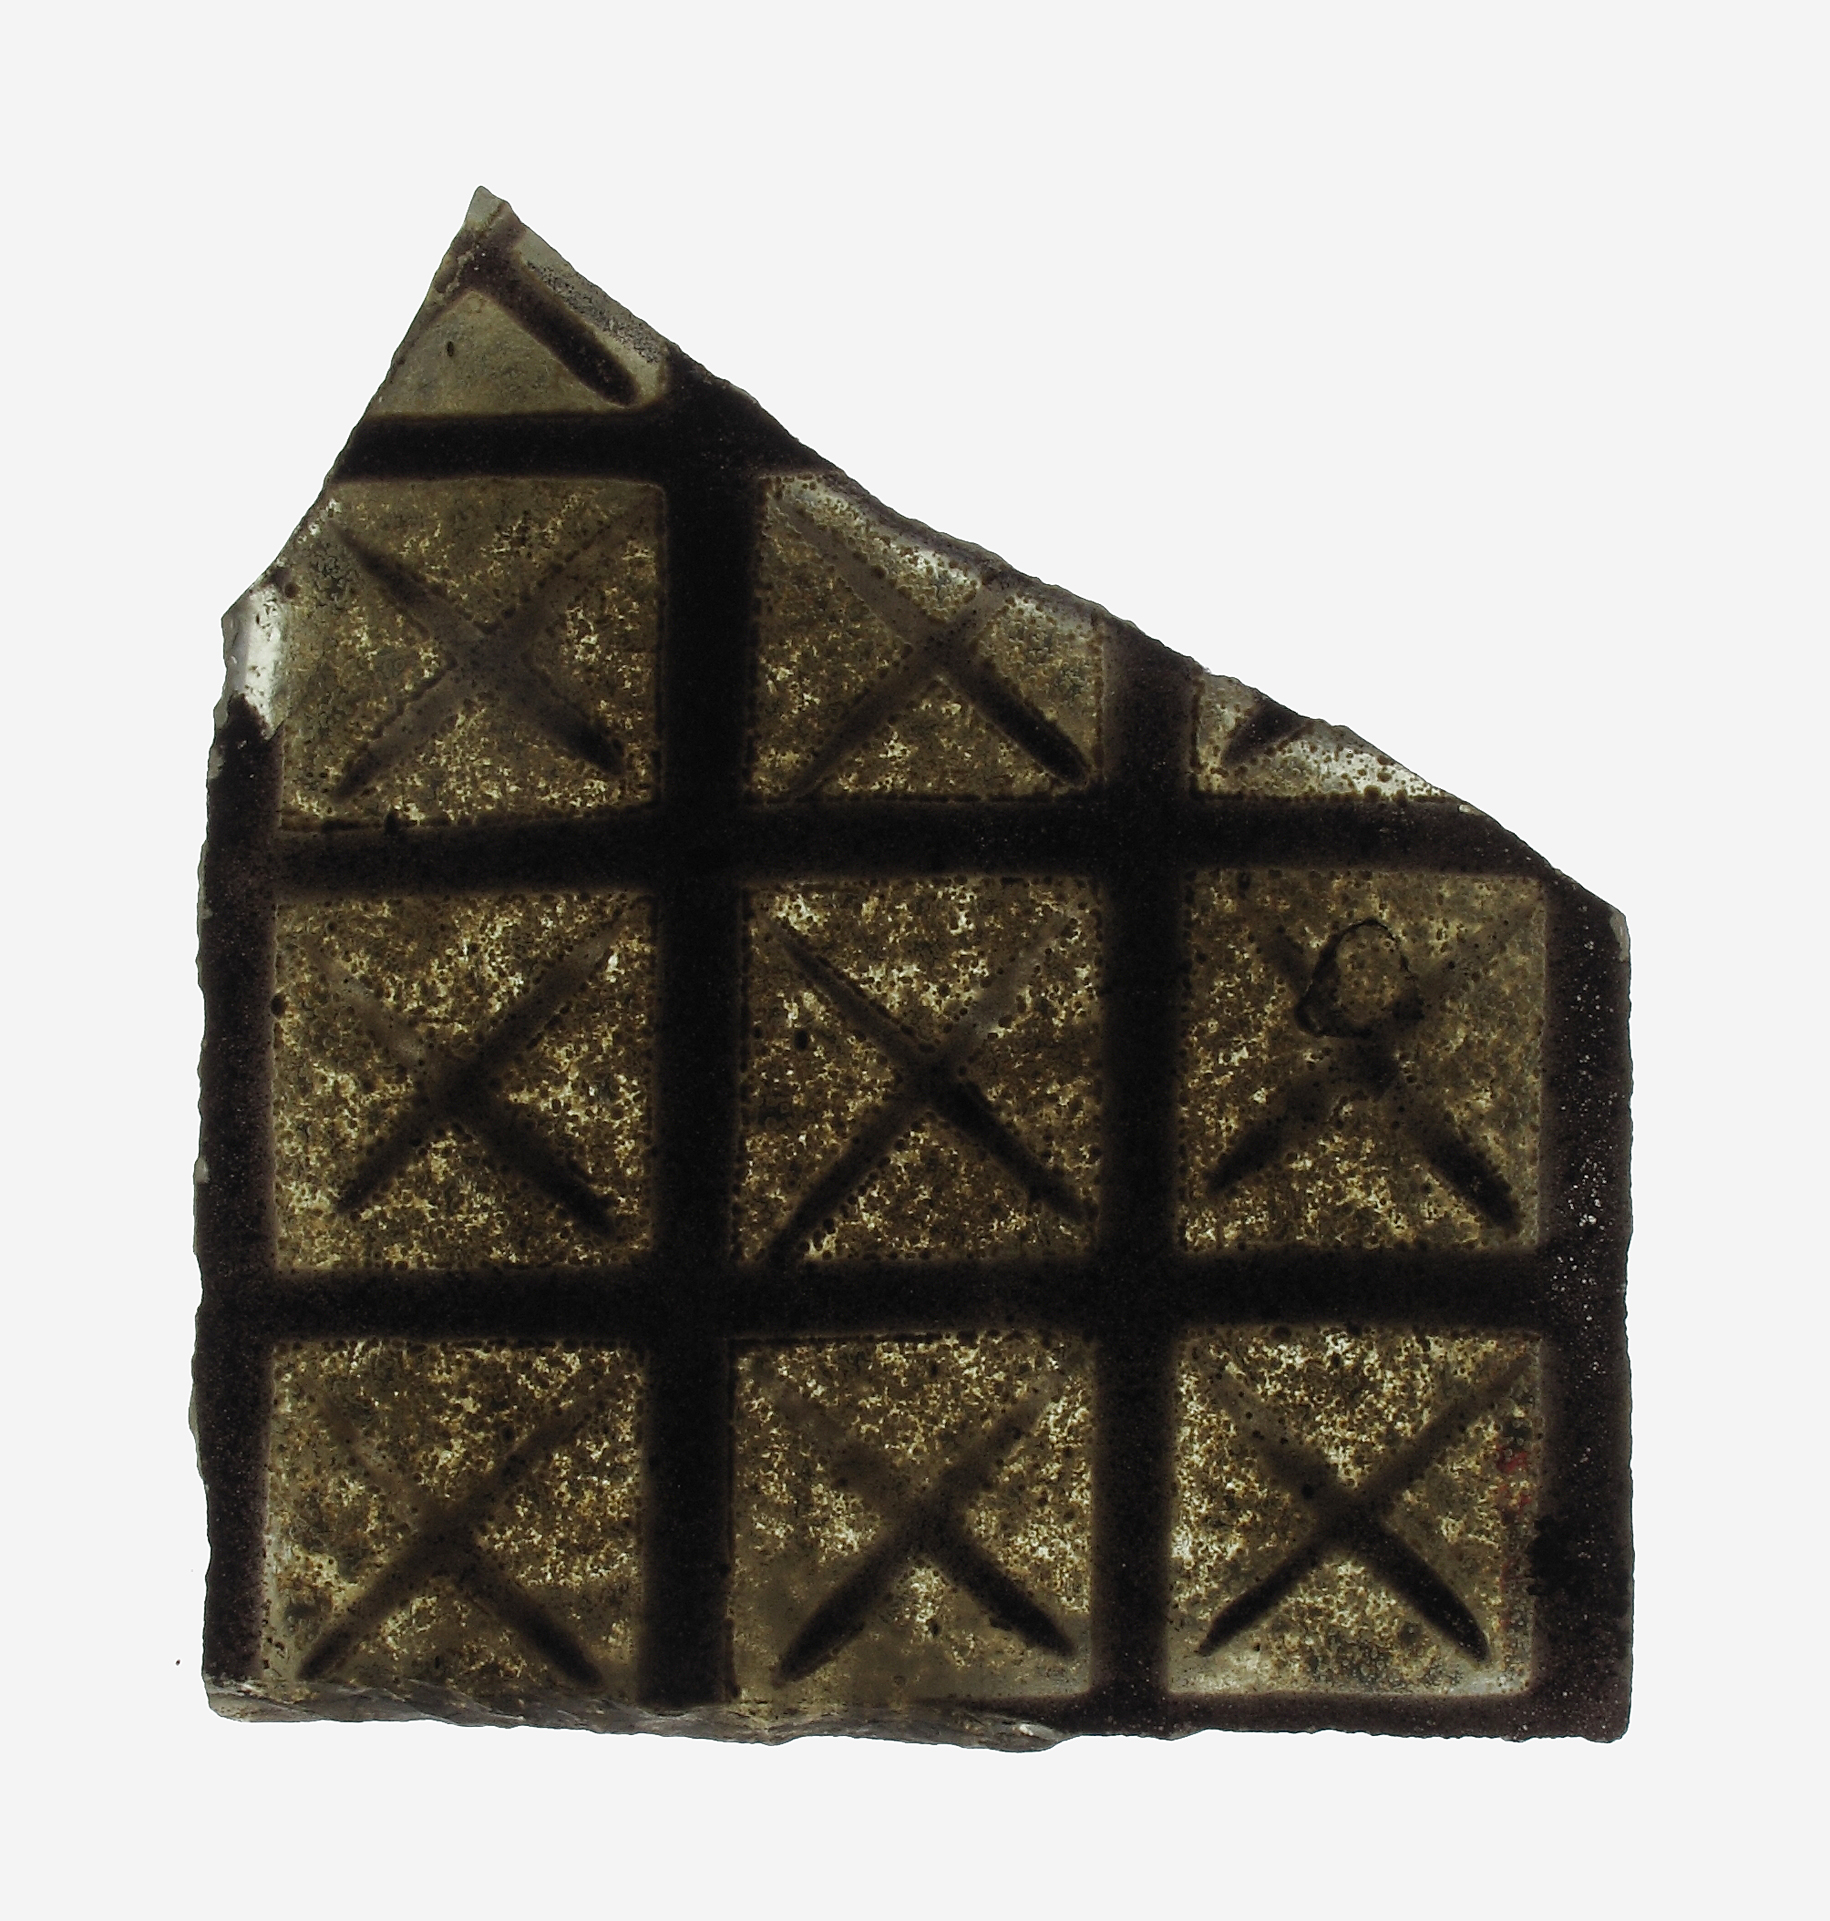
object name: fragment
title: Glass Fragment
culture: european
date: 1301-1500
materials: glass